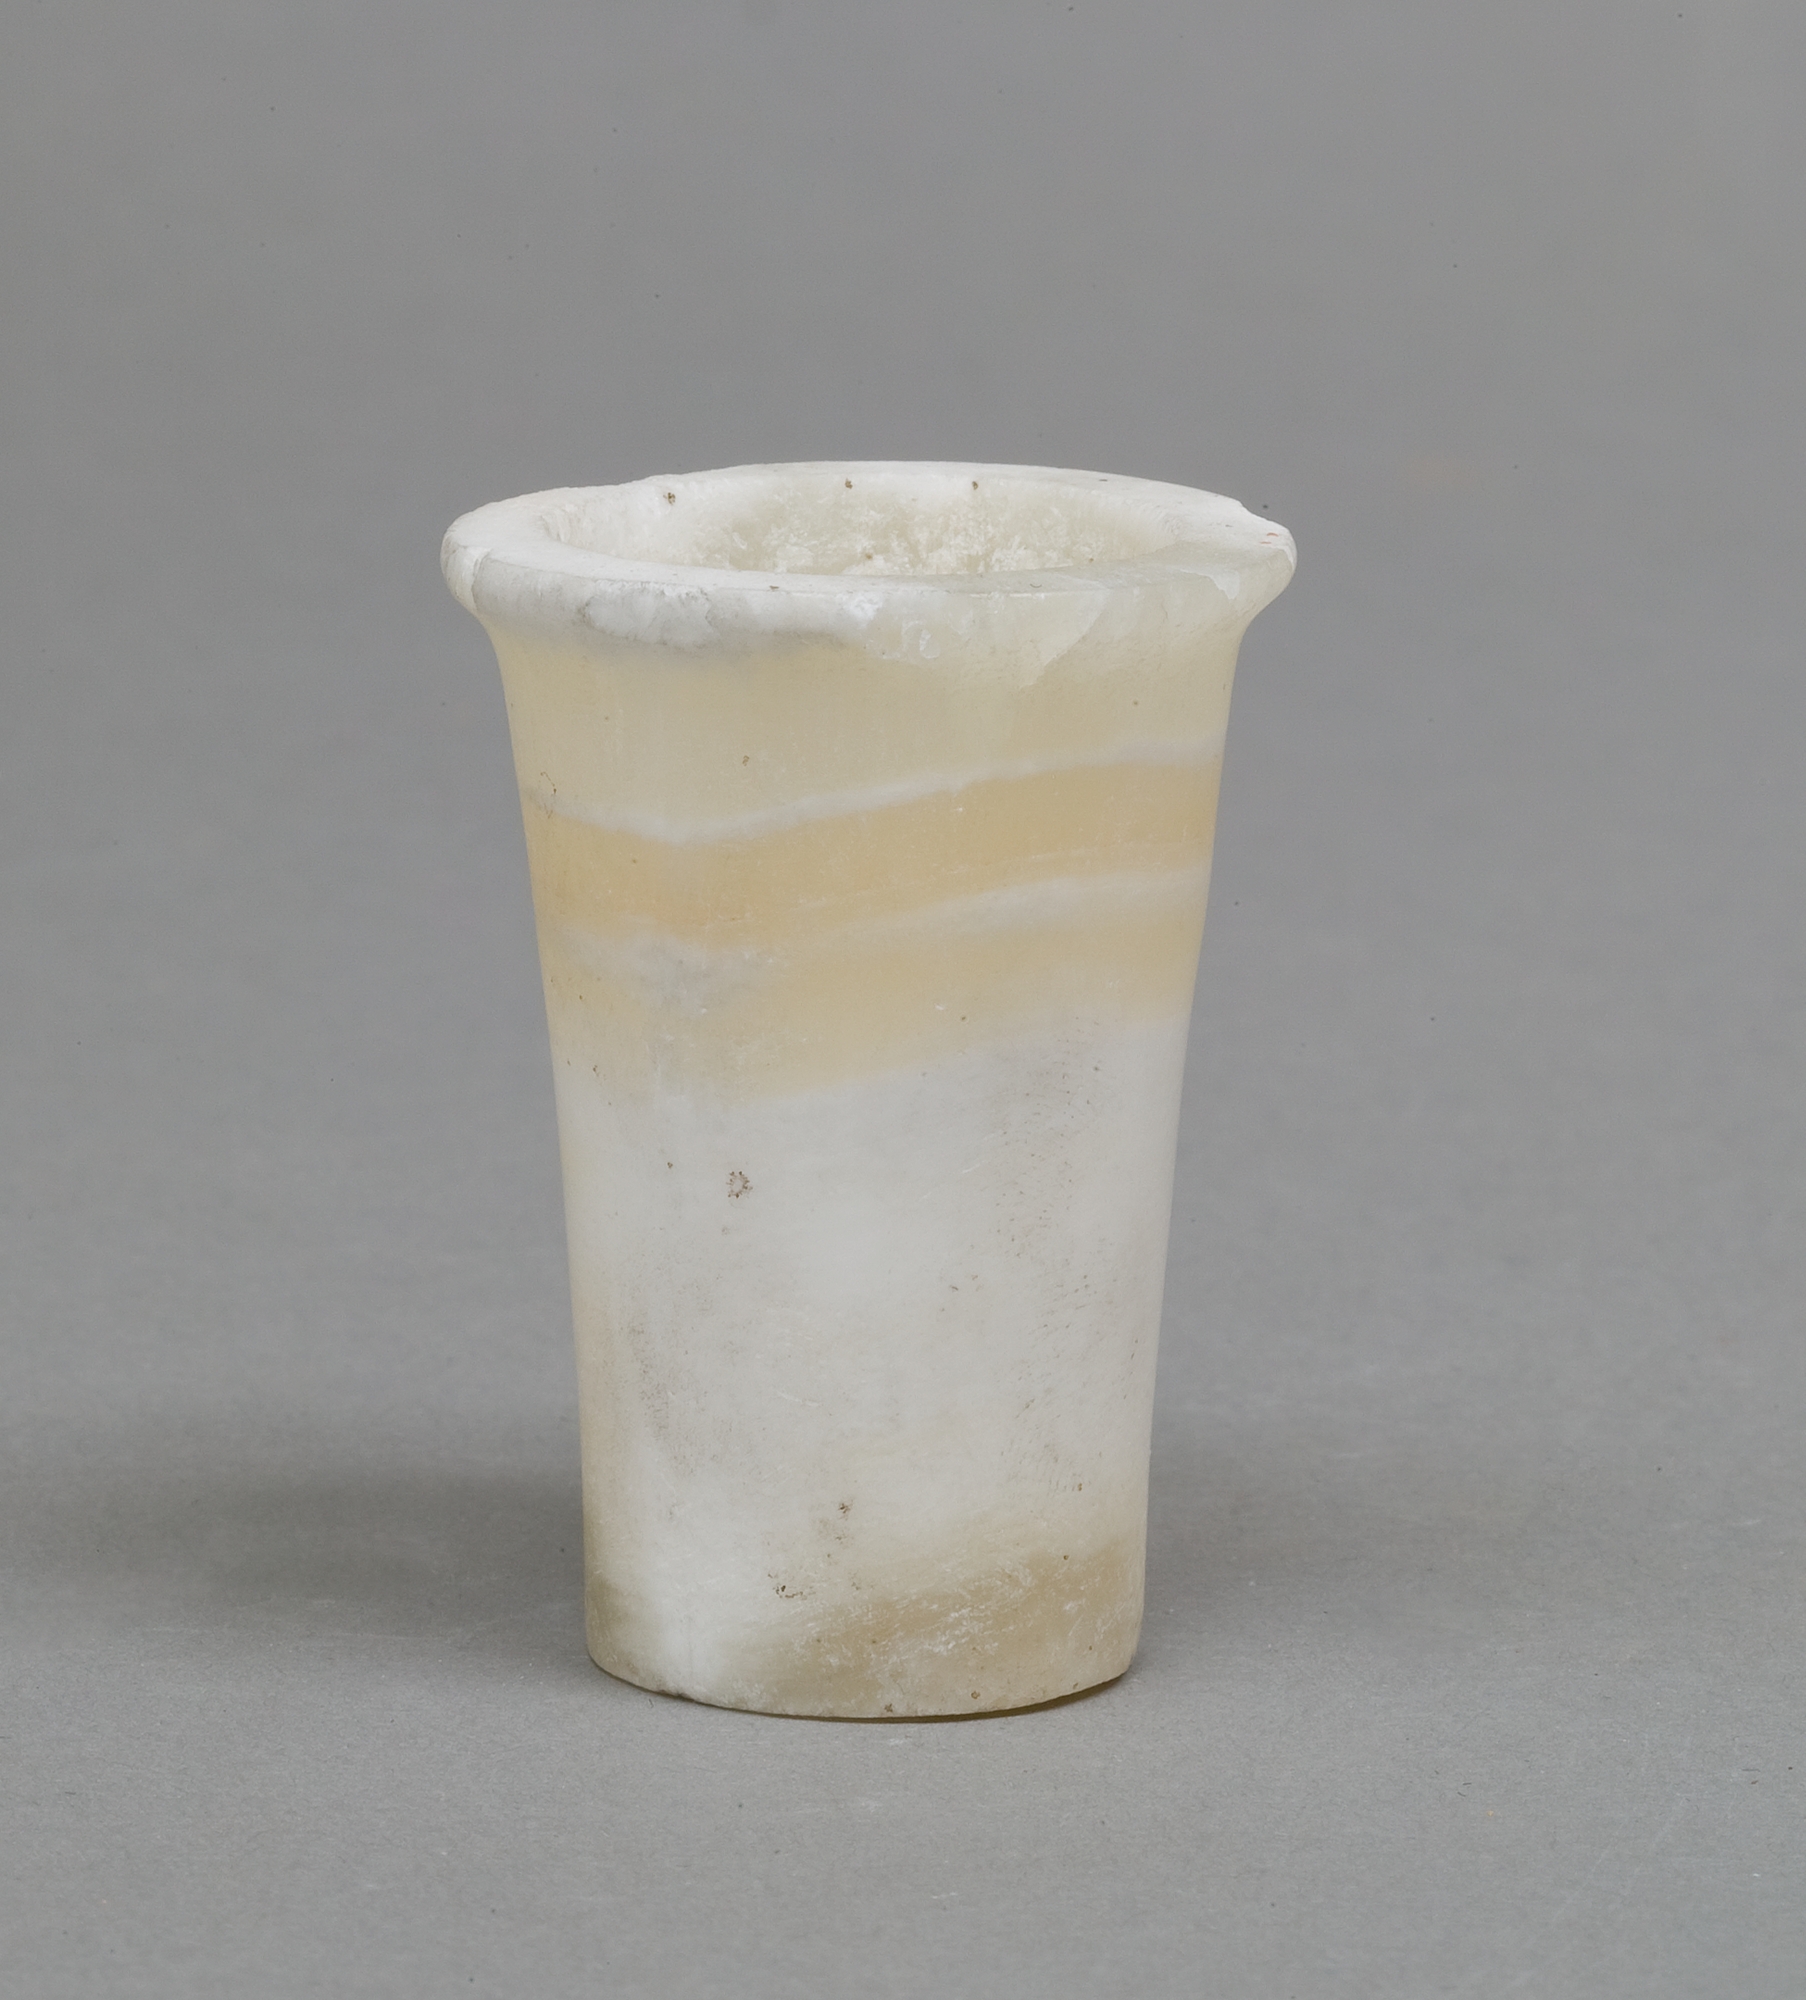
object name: jar, oil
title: Senwosret (?), Oil jar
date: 1950-1850 BCE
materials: stone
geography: egypt